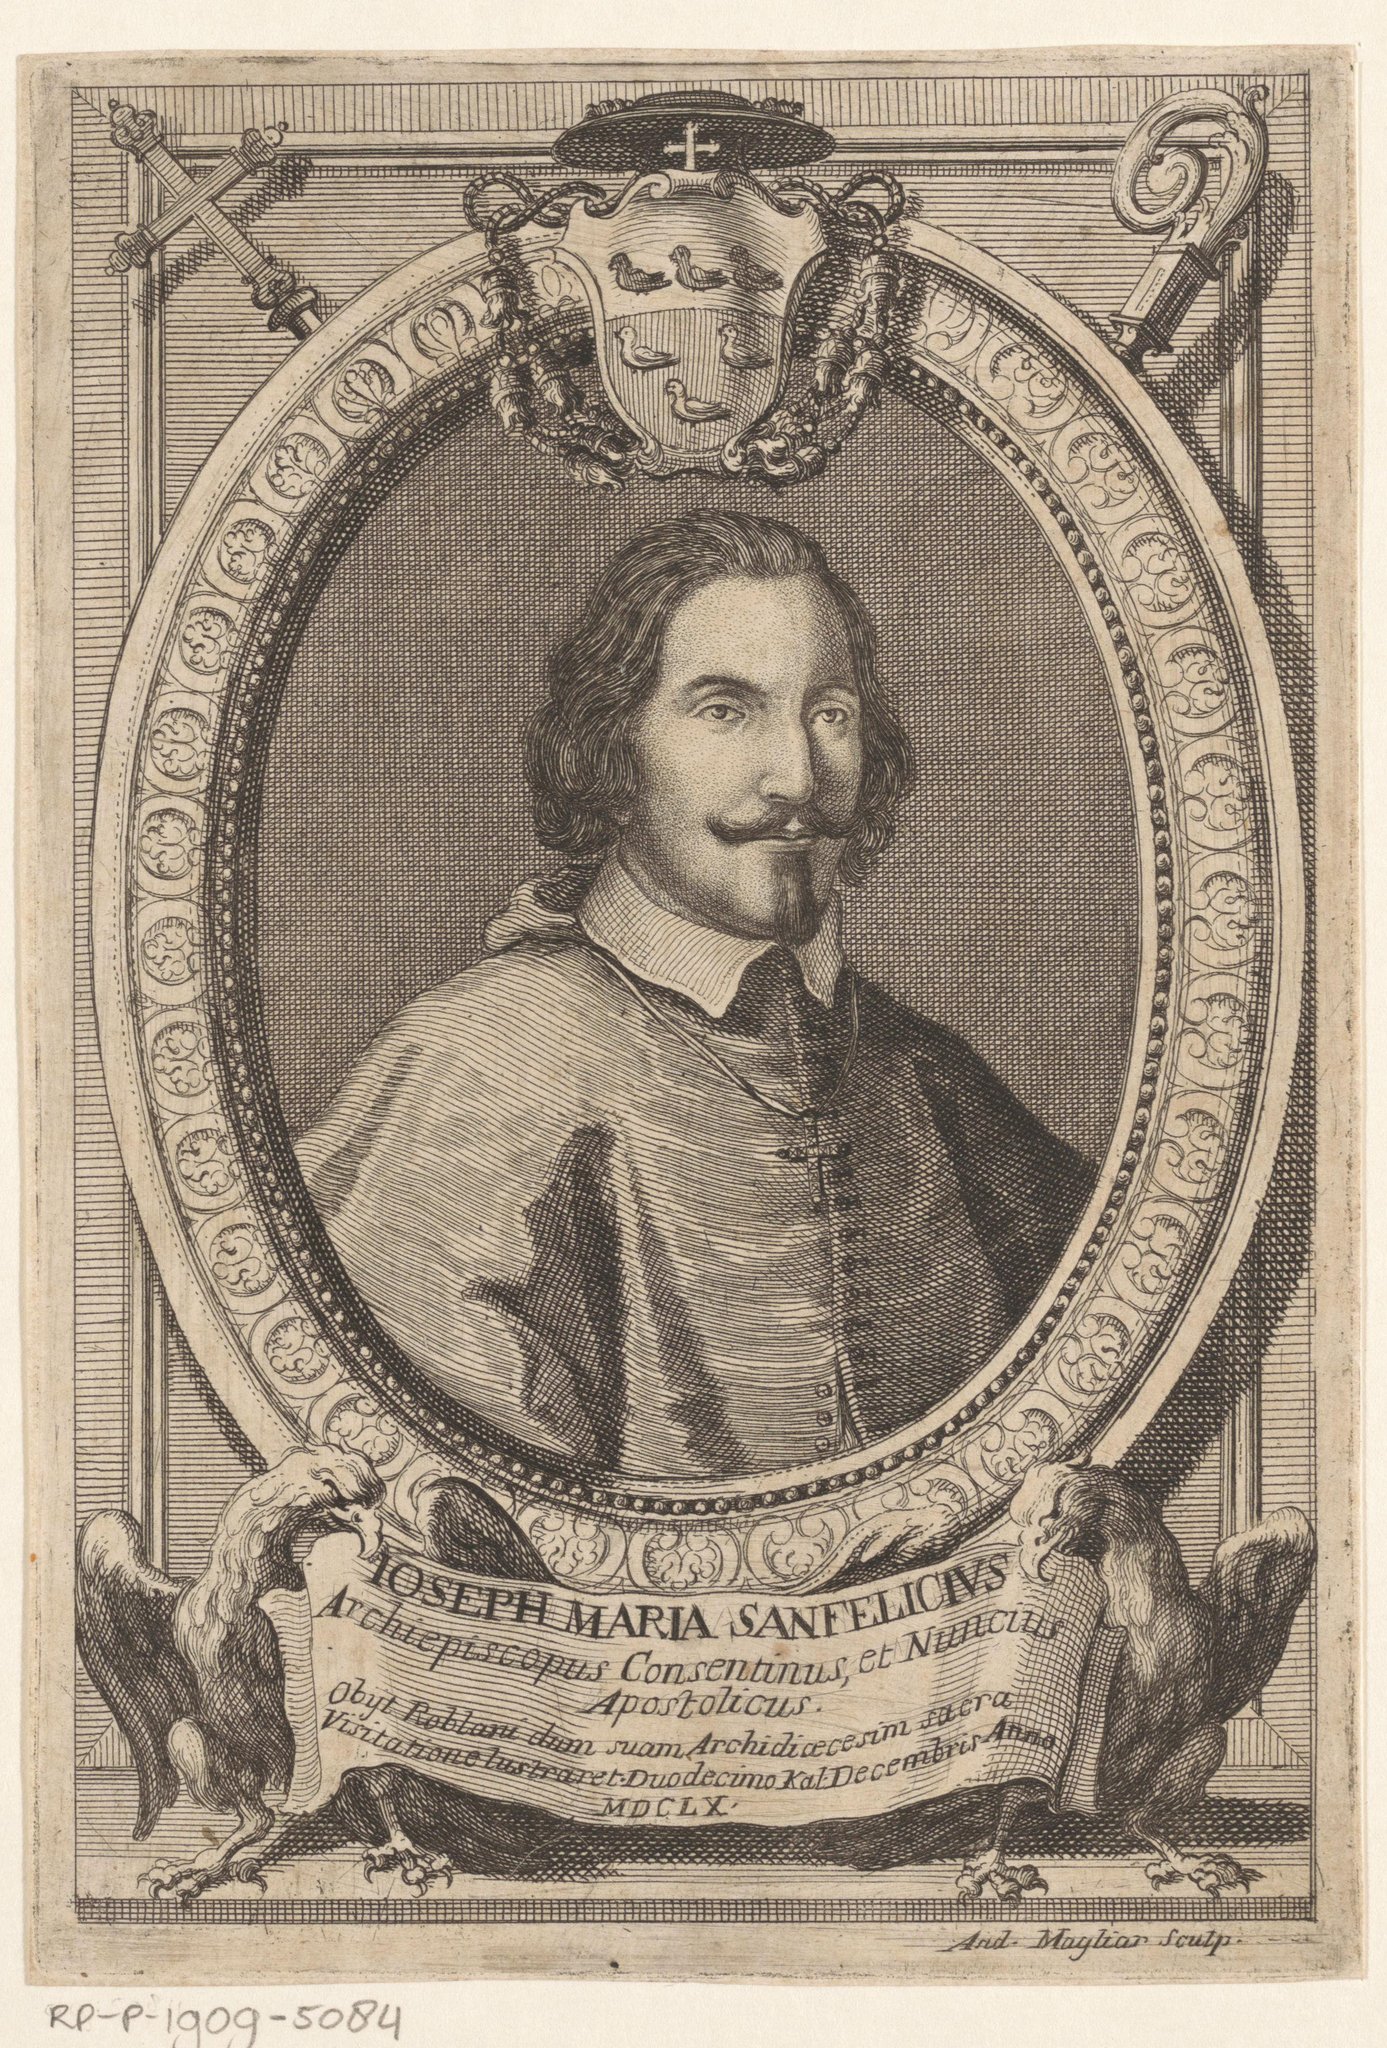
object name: print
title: Portret van aartsbisschop Giuseppe Francisco Maria Sanfelice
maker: andrea magliar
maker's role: draughtsman, print maker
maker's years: 1690-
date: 1700-1799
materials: paper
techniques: etching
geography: italy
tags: naples, archbishop, bishop, etc. (roman catholic), historical persons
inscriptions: collector's mark: Lugt 2228